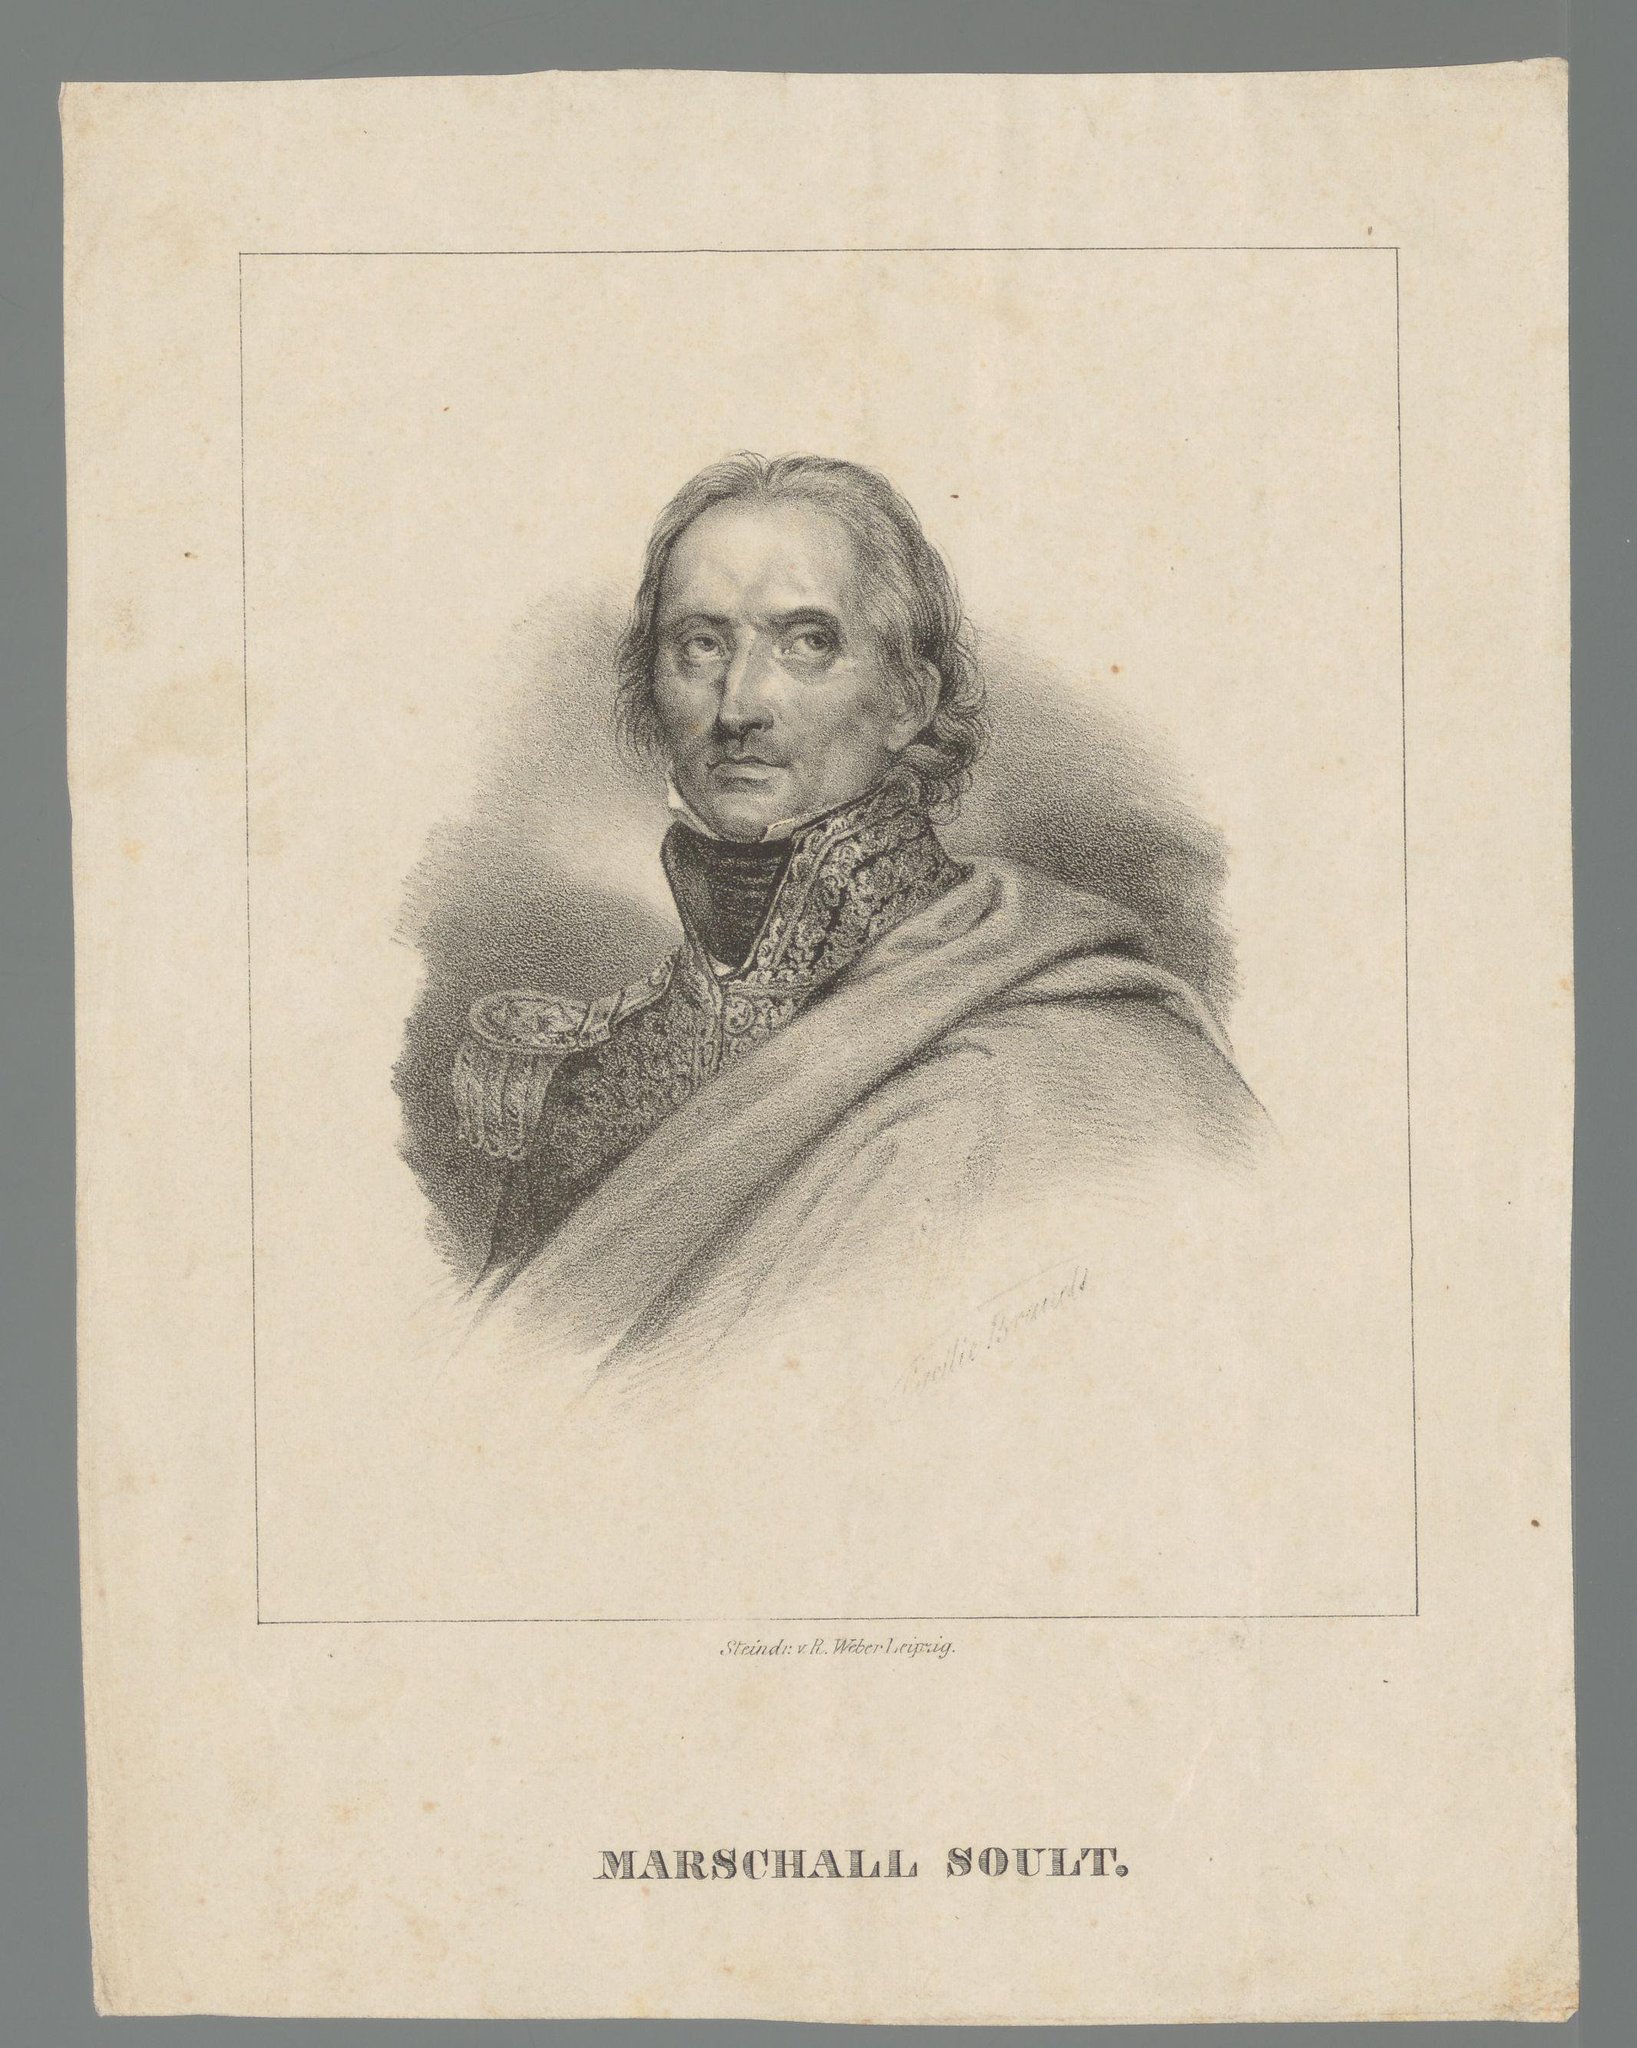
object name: print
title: Portret van Nicolas Jean-de-Dieu Soult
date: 1825-1850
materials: paper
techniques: lithograph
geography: leipzig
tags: adult man, historical persons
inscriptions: collector's mark: Lugt 2228